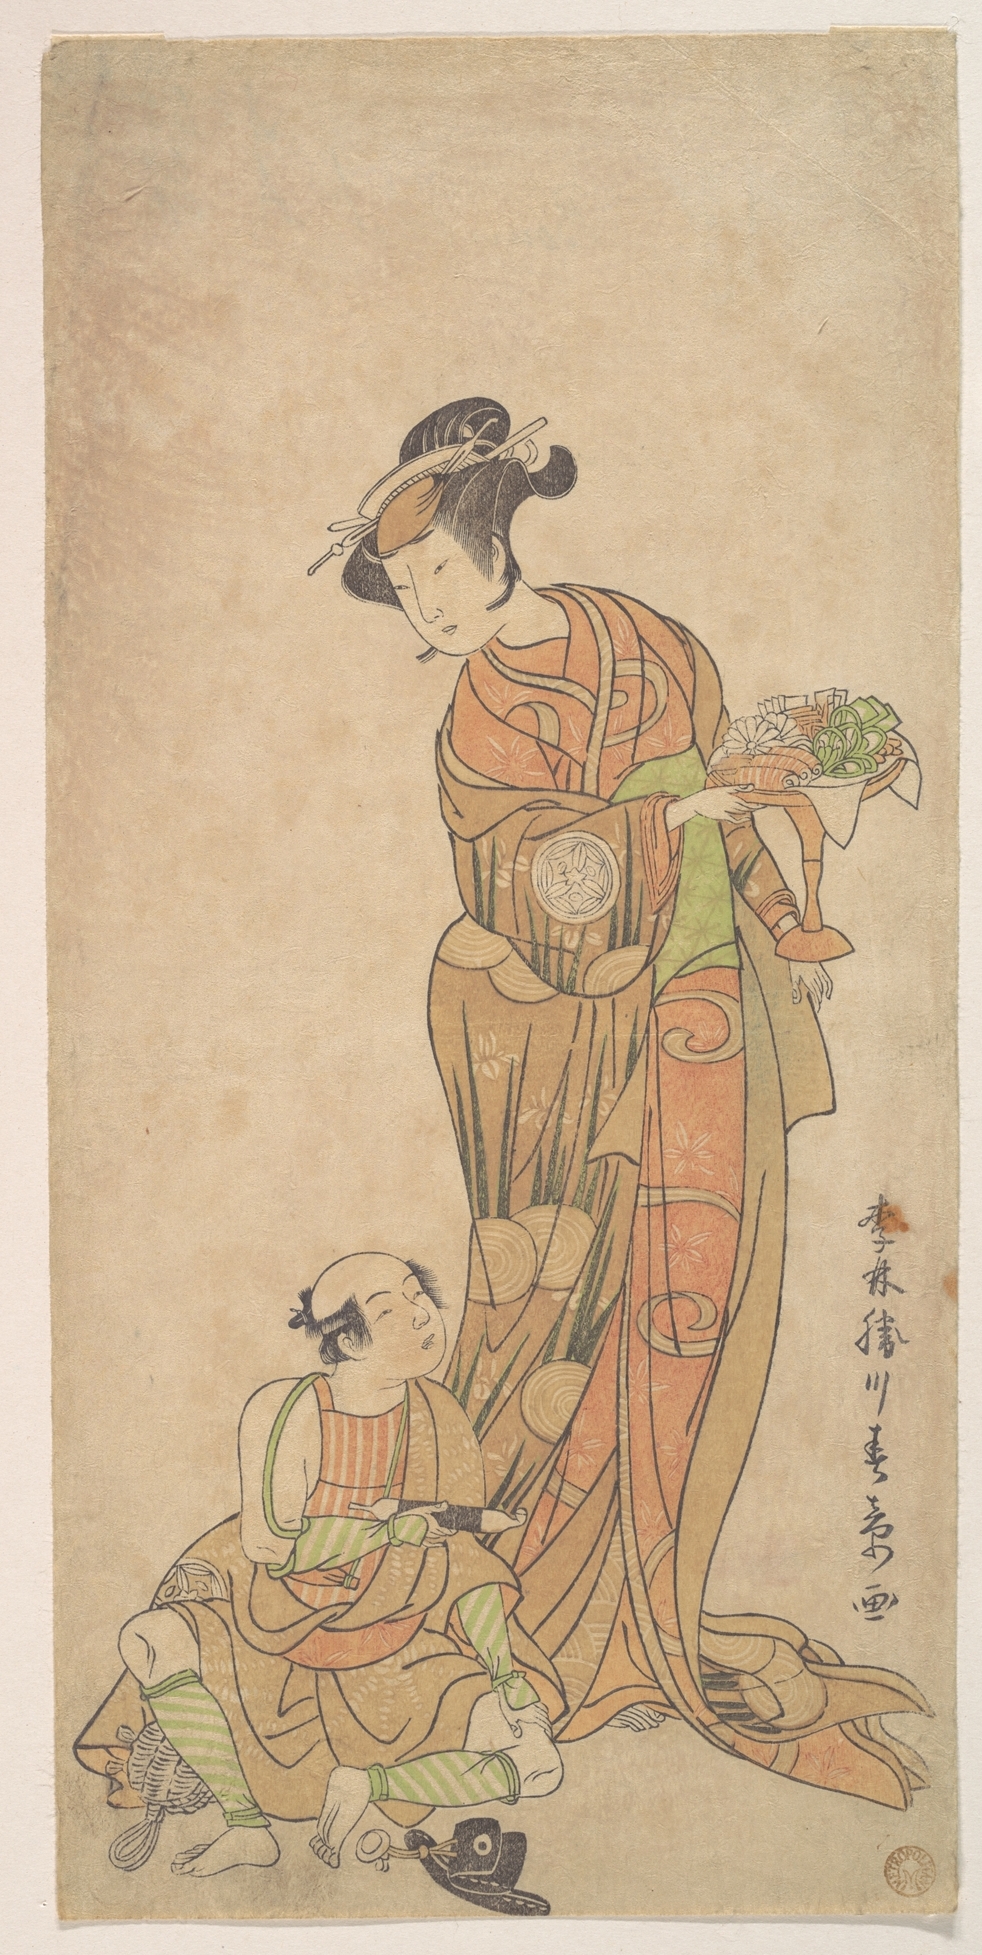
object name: woodblock print nishiki e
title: The Second Yamashita Kinsaku in the Role of Shigenoi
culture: japanese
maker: katsukawa shunshō 勝川春章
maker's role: artist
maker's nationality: japanese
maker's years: 1726-1792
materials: ink, paper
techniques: nishiki e, woodblock print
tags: boys,women,actors,pipes